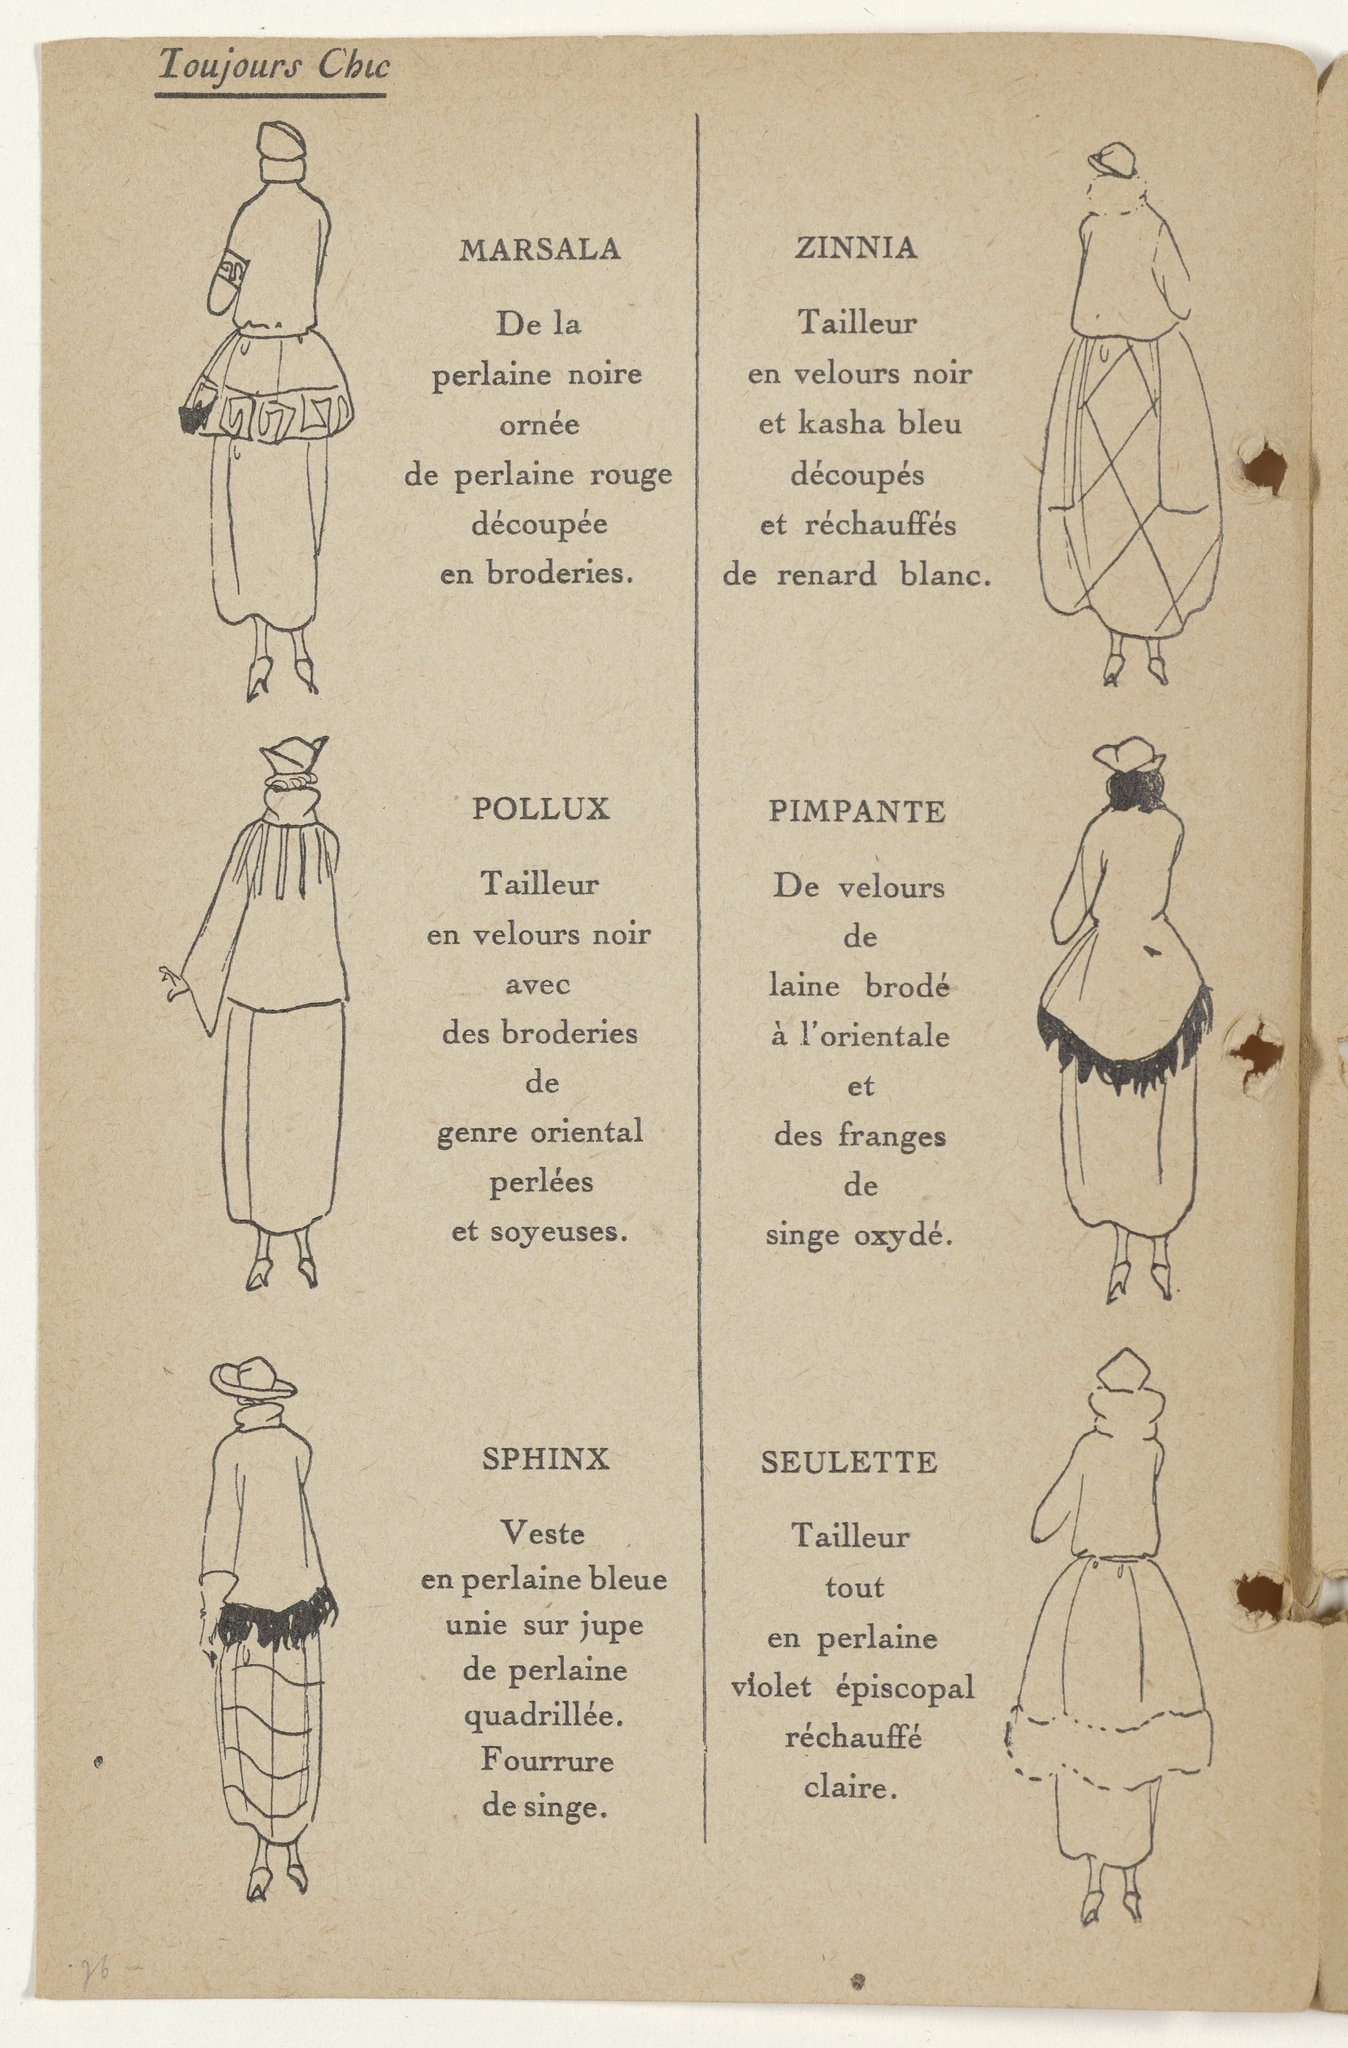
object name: fashion print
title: Toujours Chic Hiver 1921-1922: index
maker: g-p. joumard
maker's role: publisher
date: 1921-1922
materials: paper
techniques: letterpress printing, pochoir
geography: paris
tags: fashion plates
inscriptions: date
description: Pagina index uit Catalogus "Toujours Chic" waarin een overzicht van de wintermode 1921-1922.